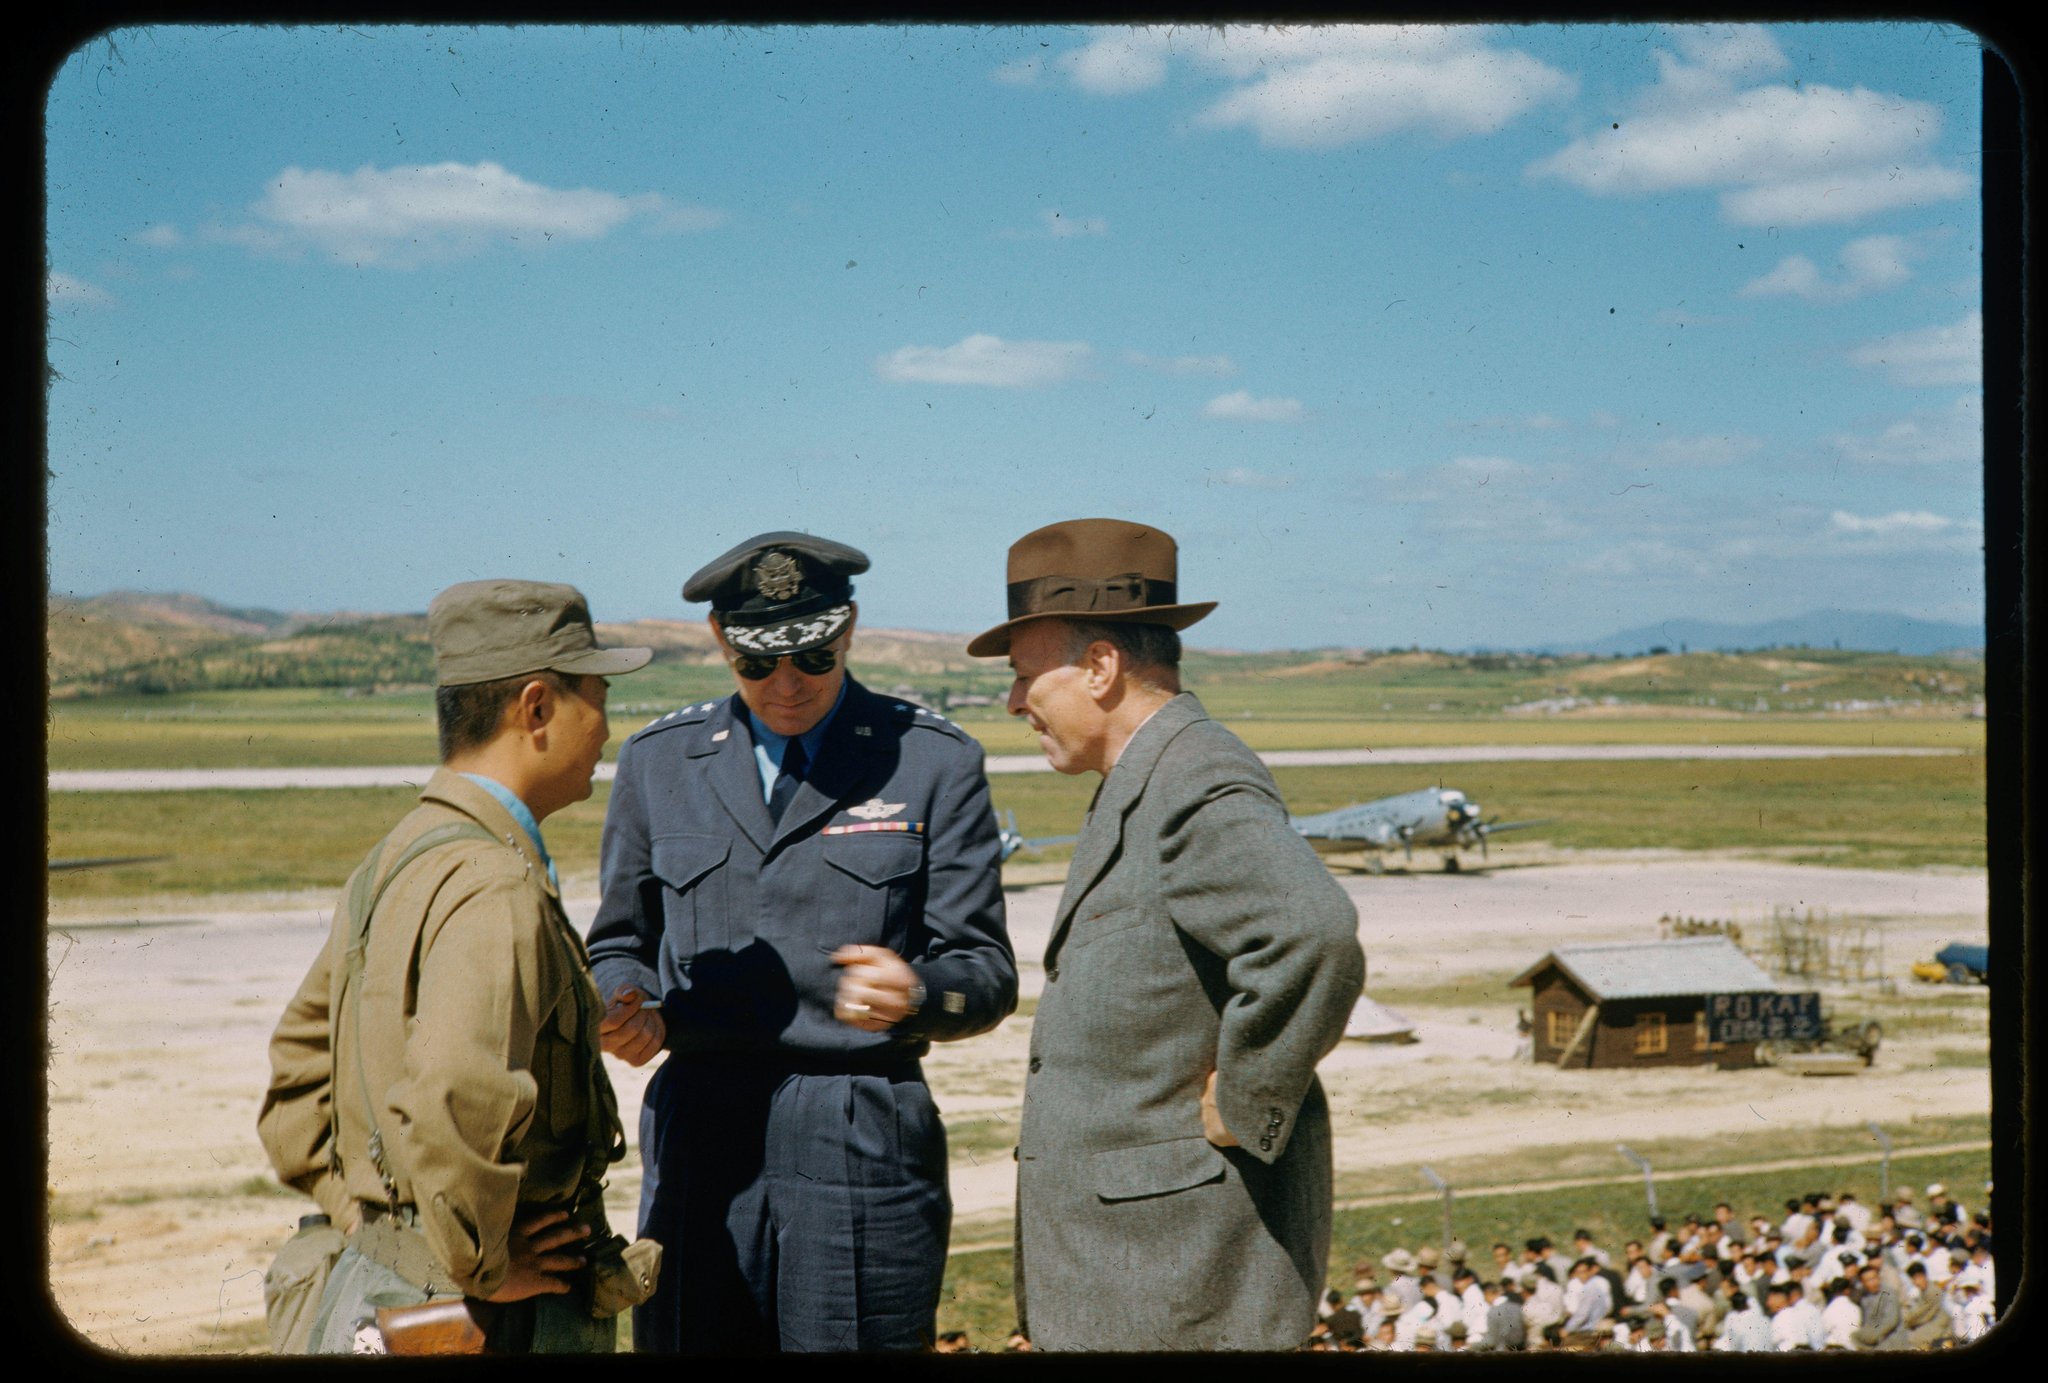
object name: color slide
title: Drie hooggeplaatste militairen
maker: david ketel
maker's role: diplomaat, sinoloog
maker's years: 1913-2008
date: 1951-1953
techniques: slide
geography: korea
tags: united nations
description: Drie mannen, v.l.n.r. Koreaanse generaal, chef staf R.O.K. (Republic of Korea, het zuiden) Pal Sun Yop, een Amerikaanse generaal en nog een Amerikaan.